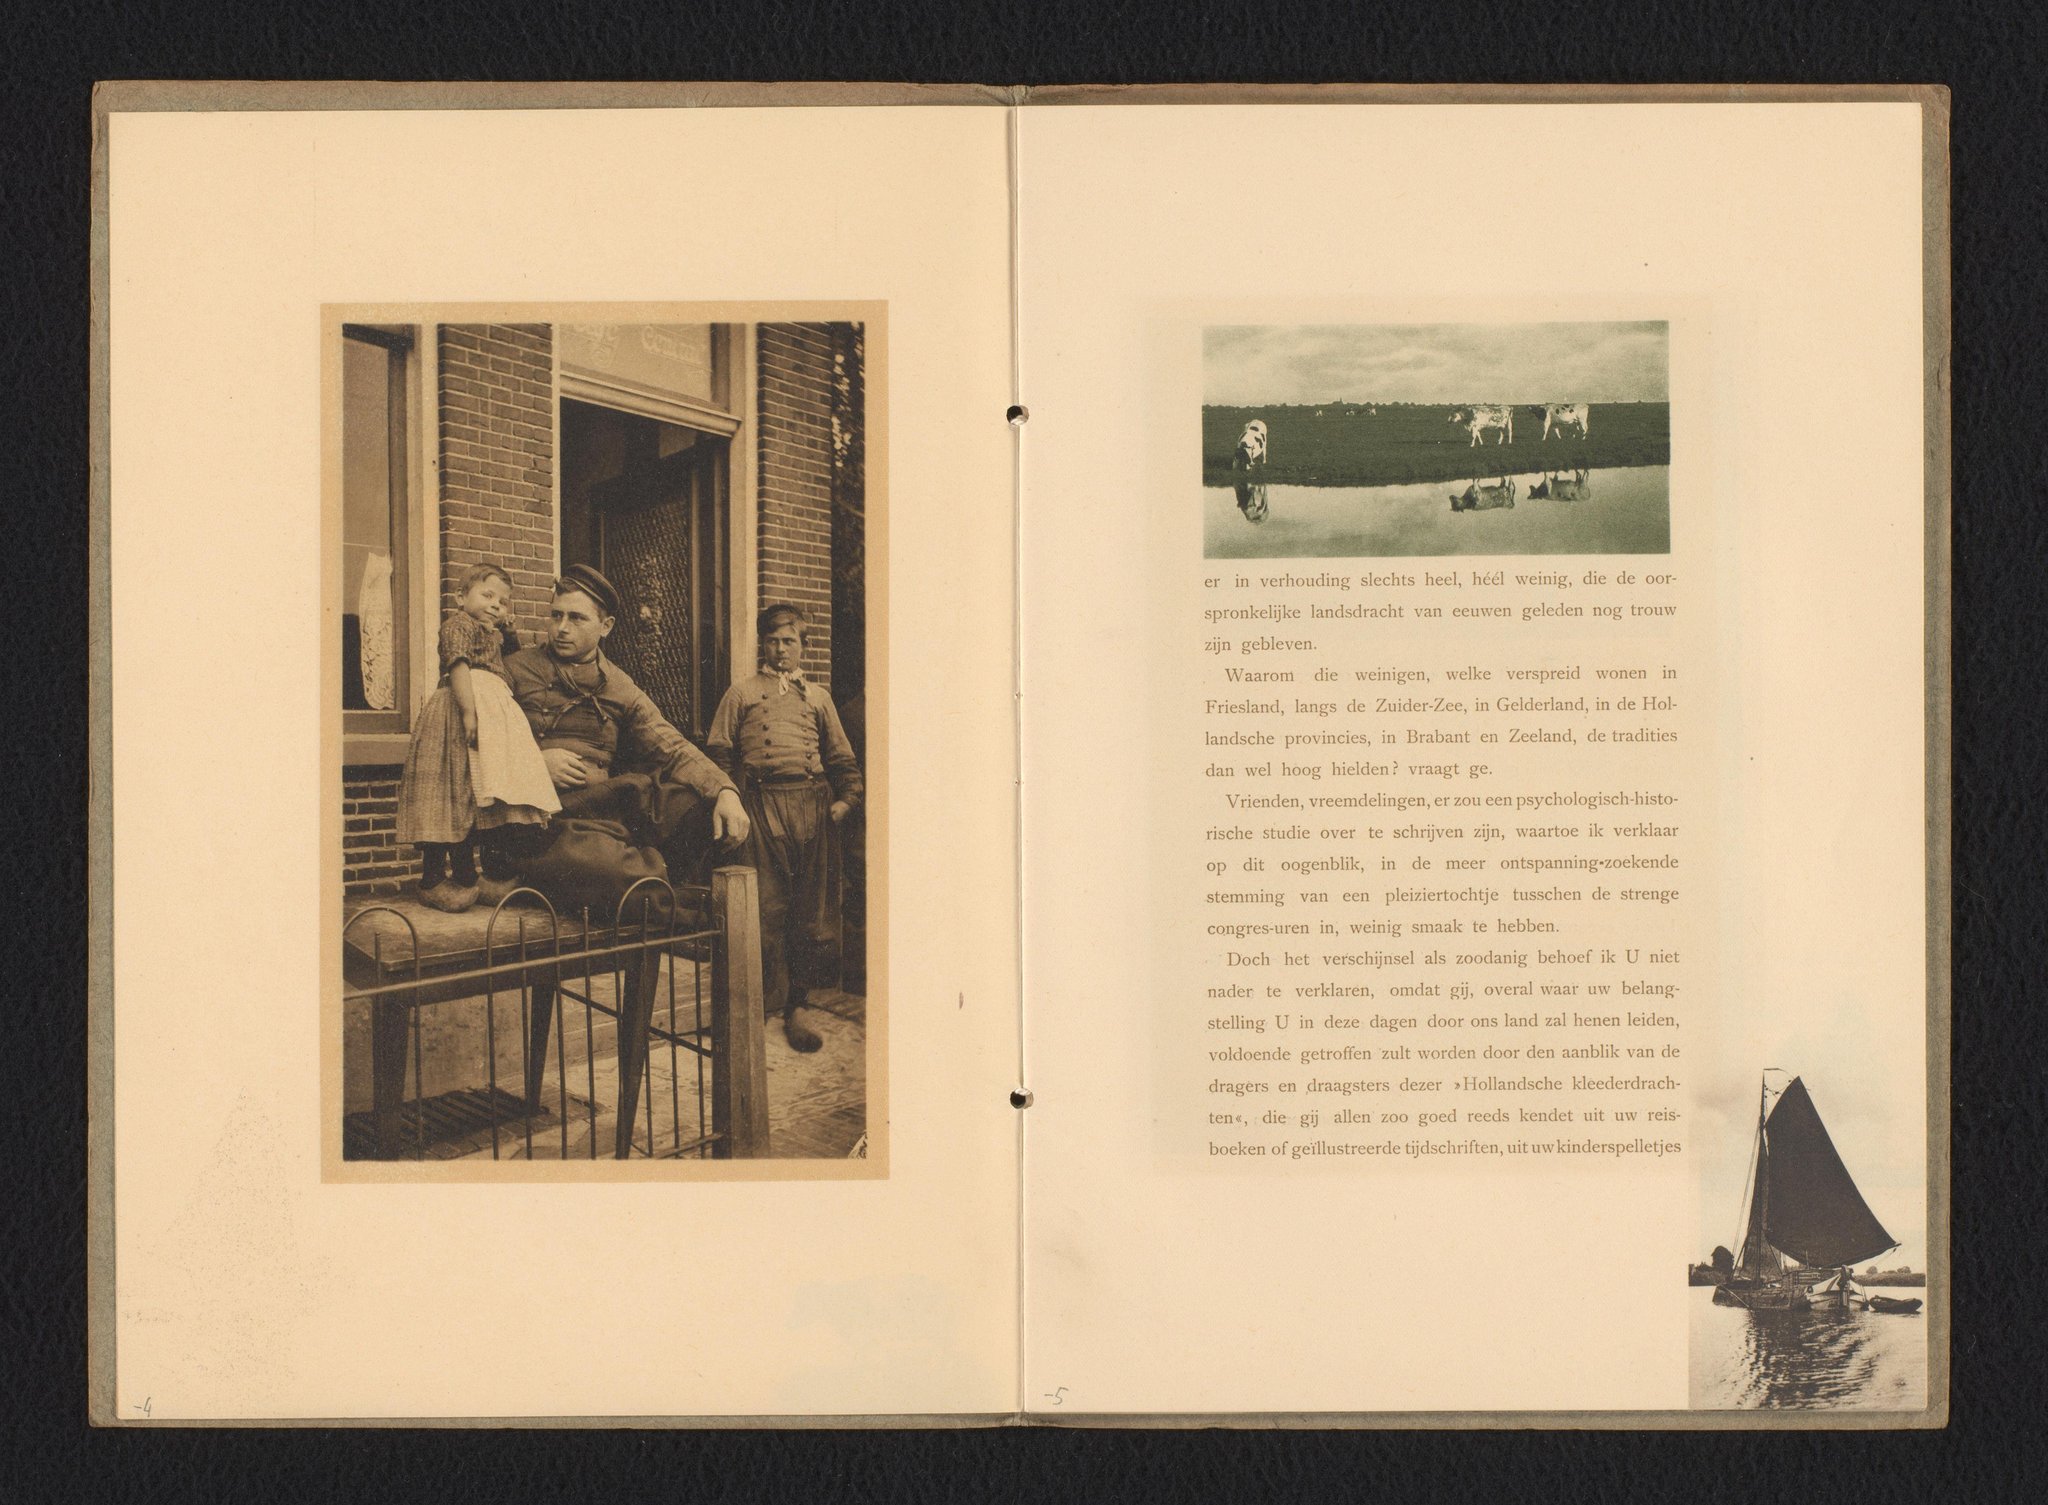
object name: photomechanical print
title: Onbekende man, jongen en kind voor een huis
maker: Anonymous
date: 1905-1910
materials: paper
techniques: photograph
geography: north holland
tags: boy (child between toddler and youth), adult man, child